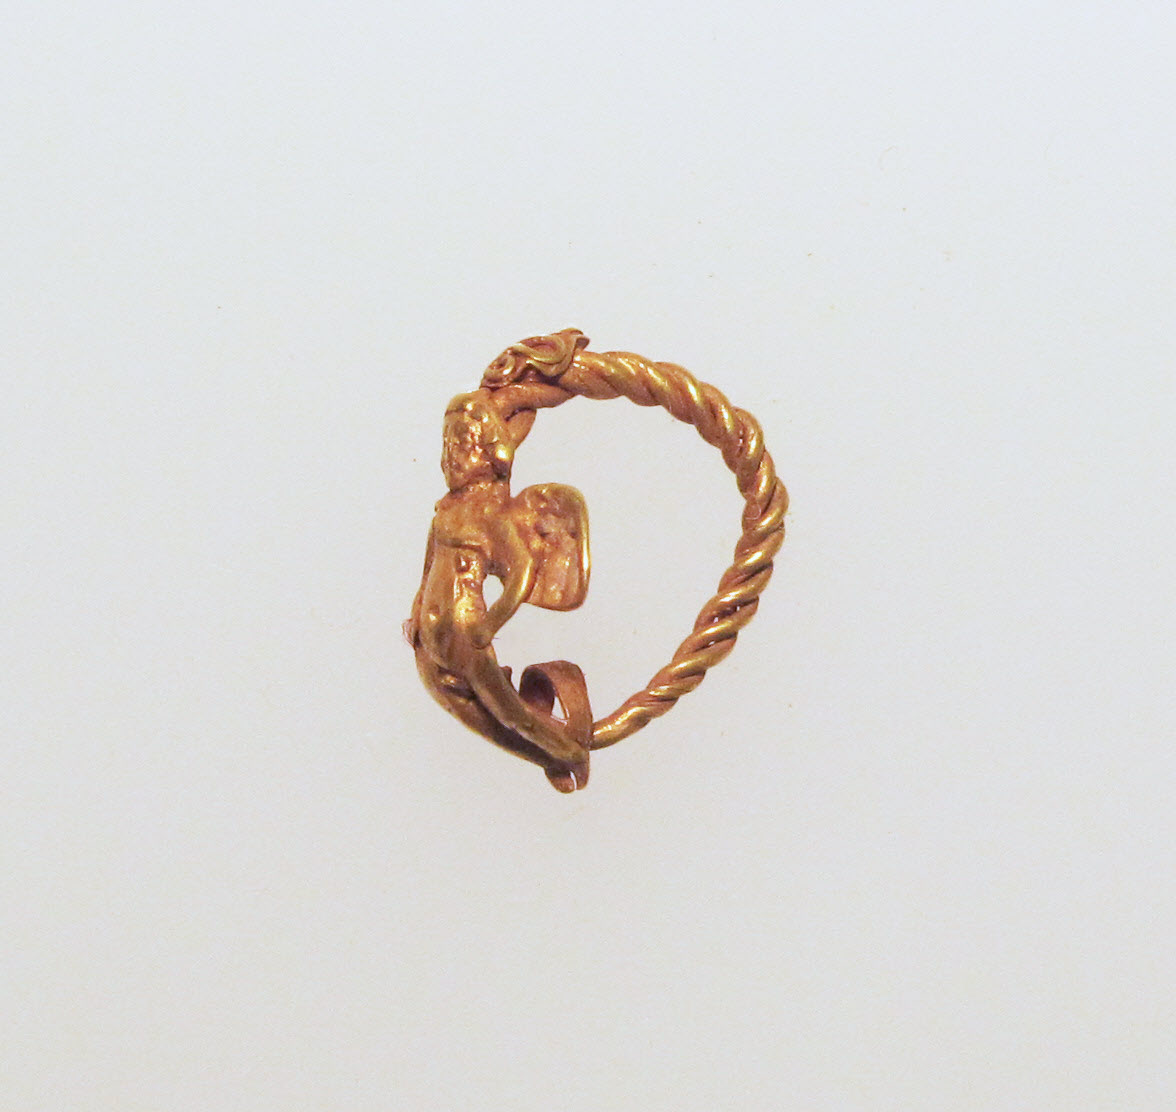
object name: earring with eros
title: Gold earring with winged Eros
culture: greek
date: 300-101 BCE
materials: gold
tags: eros